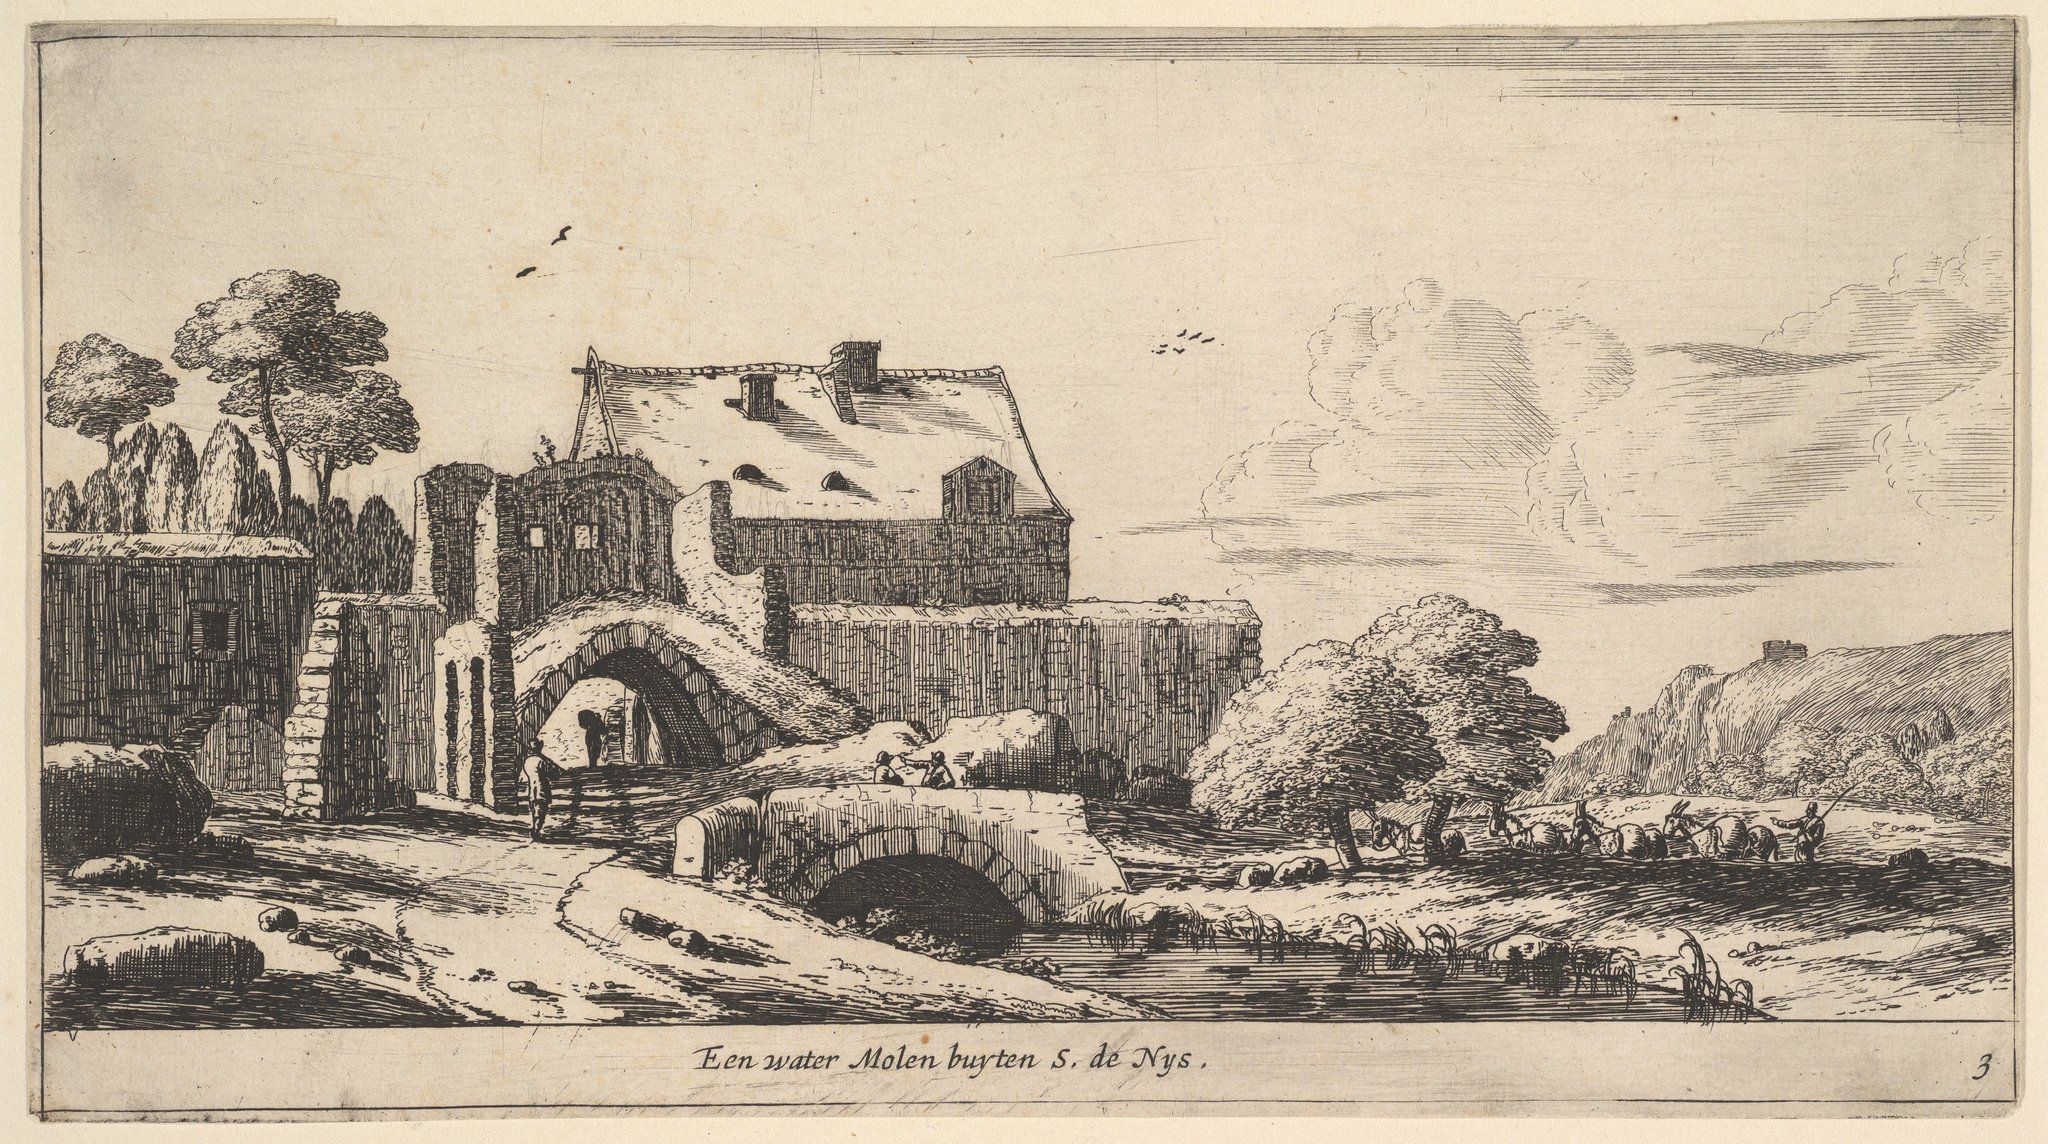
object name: print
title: A Water Mill near St. Denis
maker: reinier nooms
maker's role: artist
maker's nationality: dutch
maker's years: 1623-1664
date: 1601-1700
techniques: etching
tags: houses,watermills,canals,landscapes,trees